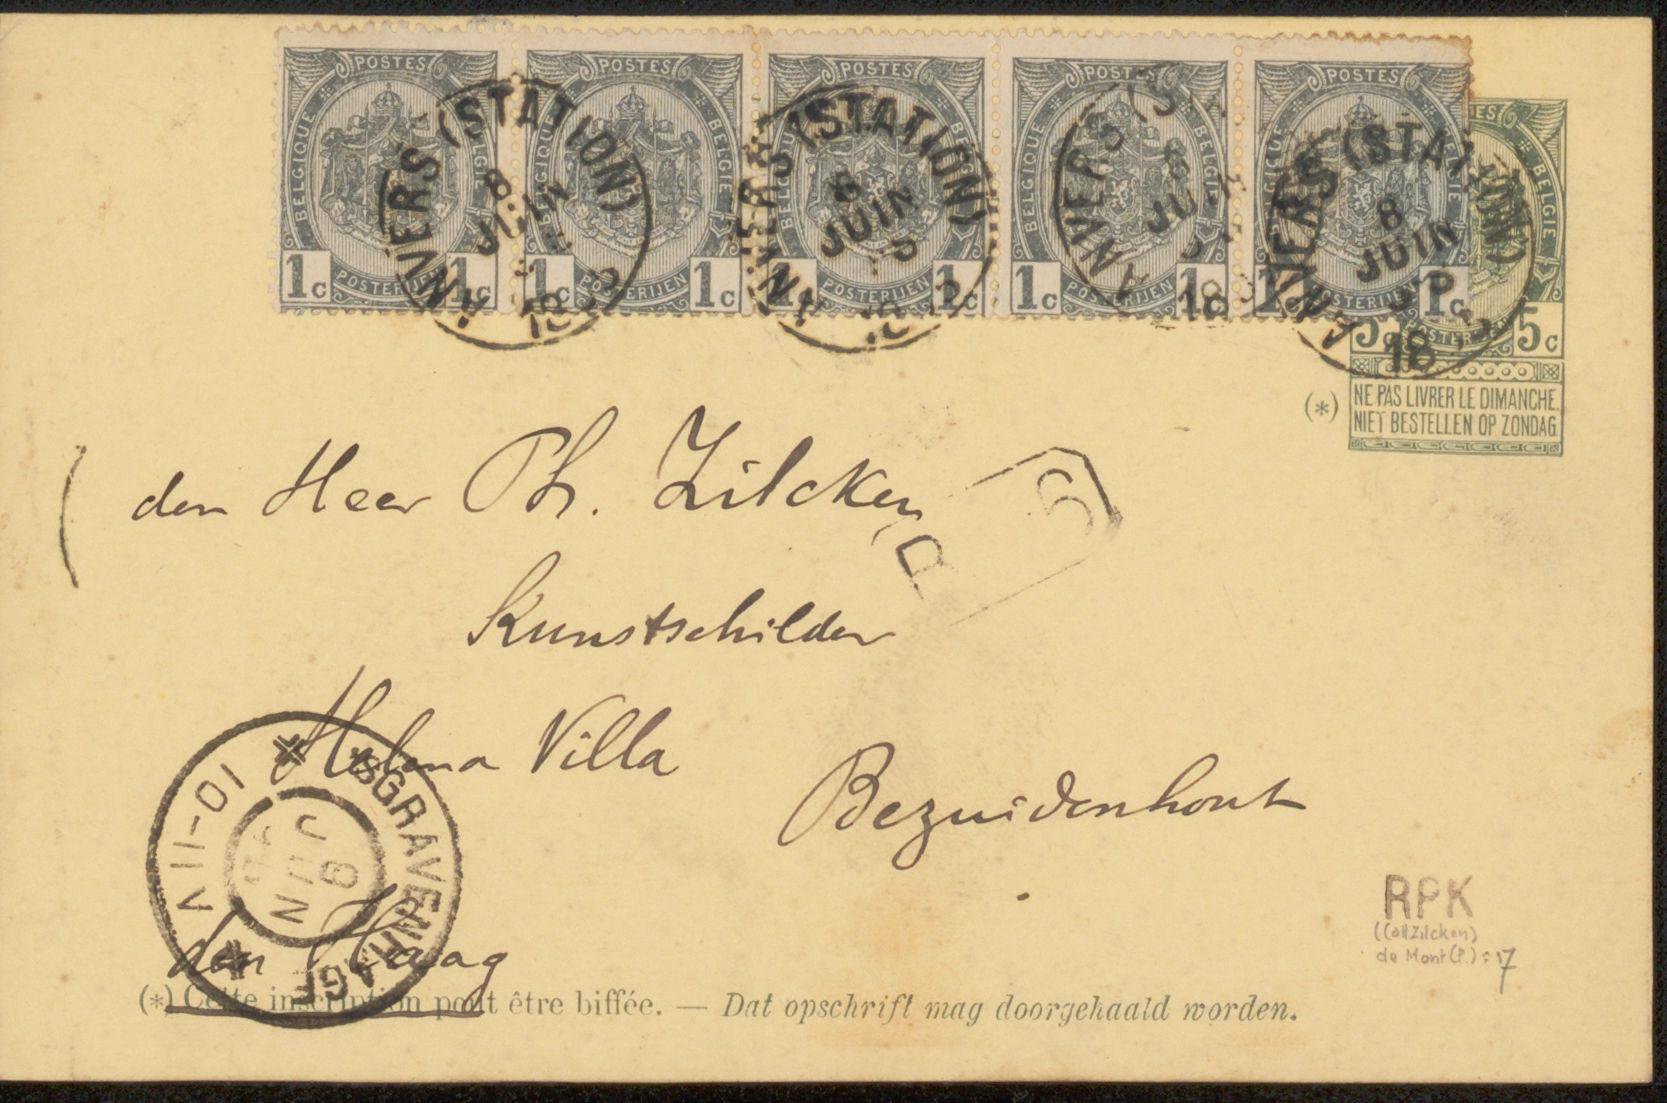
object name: postcard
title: Briefkaart aan Philip Zilcken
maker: pol de mont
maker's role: dichter, prozaschrijver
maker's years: 1857-1931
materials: cardboard, ink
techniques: pen, writing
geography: antwerp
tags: fernand khnopff, paris, painter, gustave moreau, print maker, draughtsman, paul gauguin, jan toorop, brussels, philip zilcken, the graphic arts, printed matter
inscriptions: collector's mark: ‘RPK’